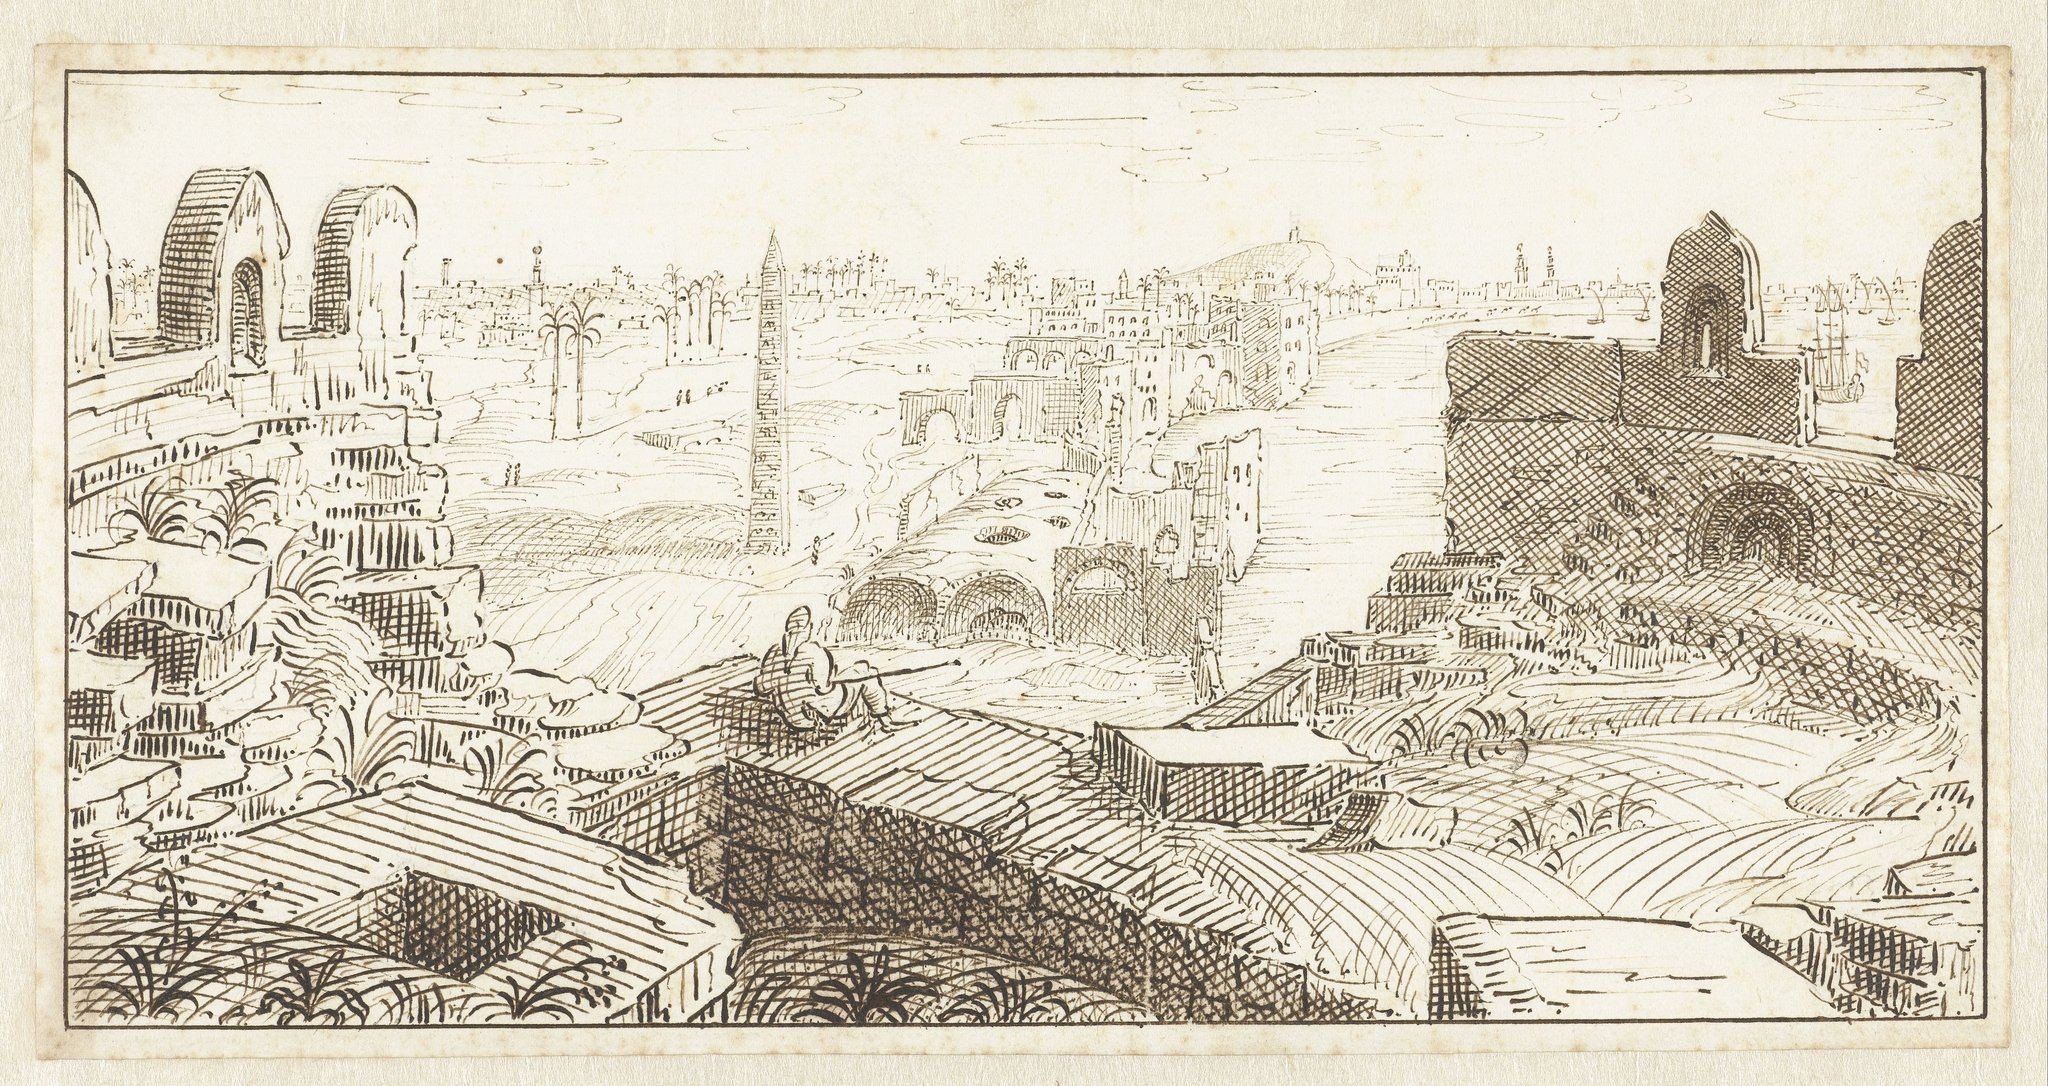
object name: drawing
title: Gezichten rond de Middellandse Zee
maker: johan teyler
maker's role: draughtsman, print maker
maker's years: 1648-1712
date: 1679-1683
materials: ink, paper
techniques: pen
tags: obelisk, needle, ruin of a building ~ architecture, landscape with ruins